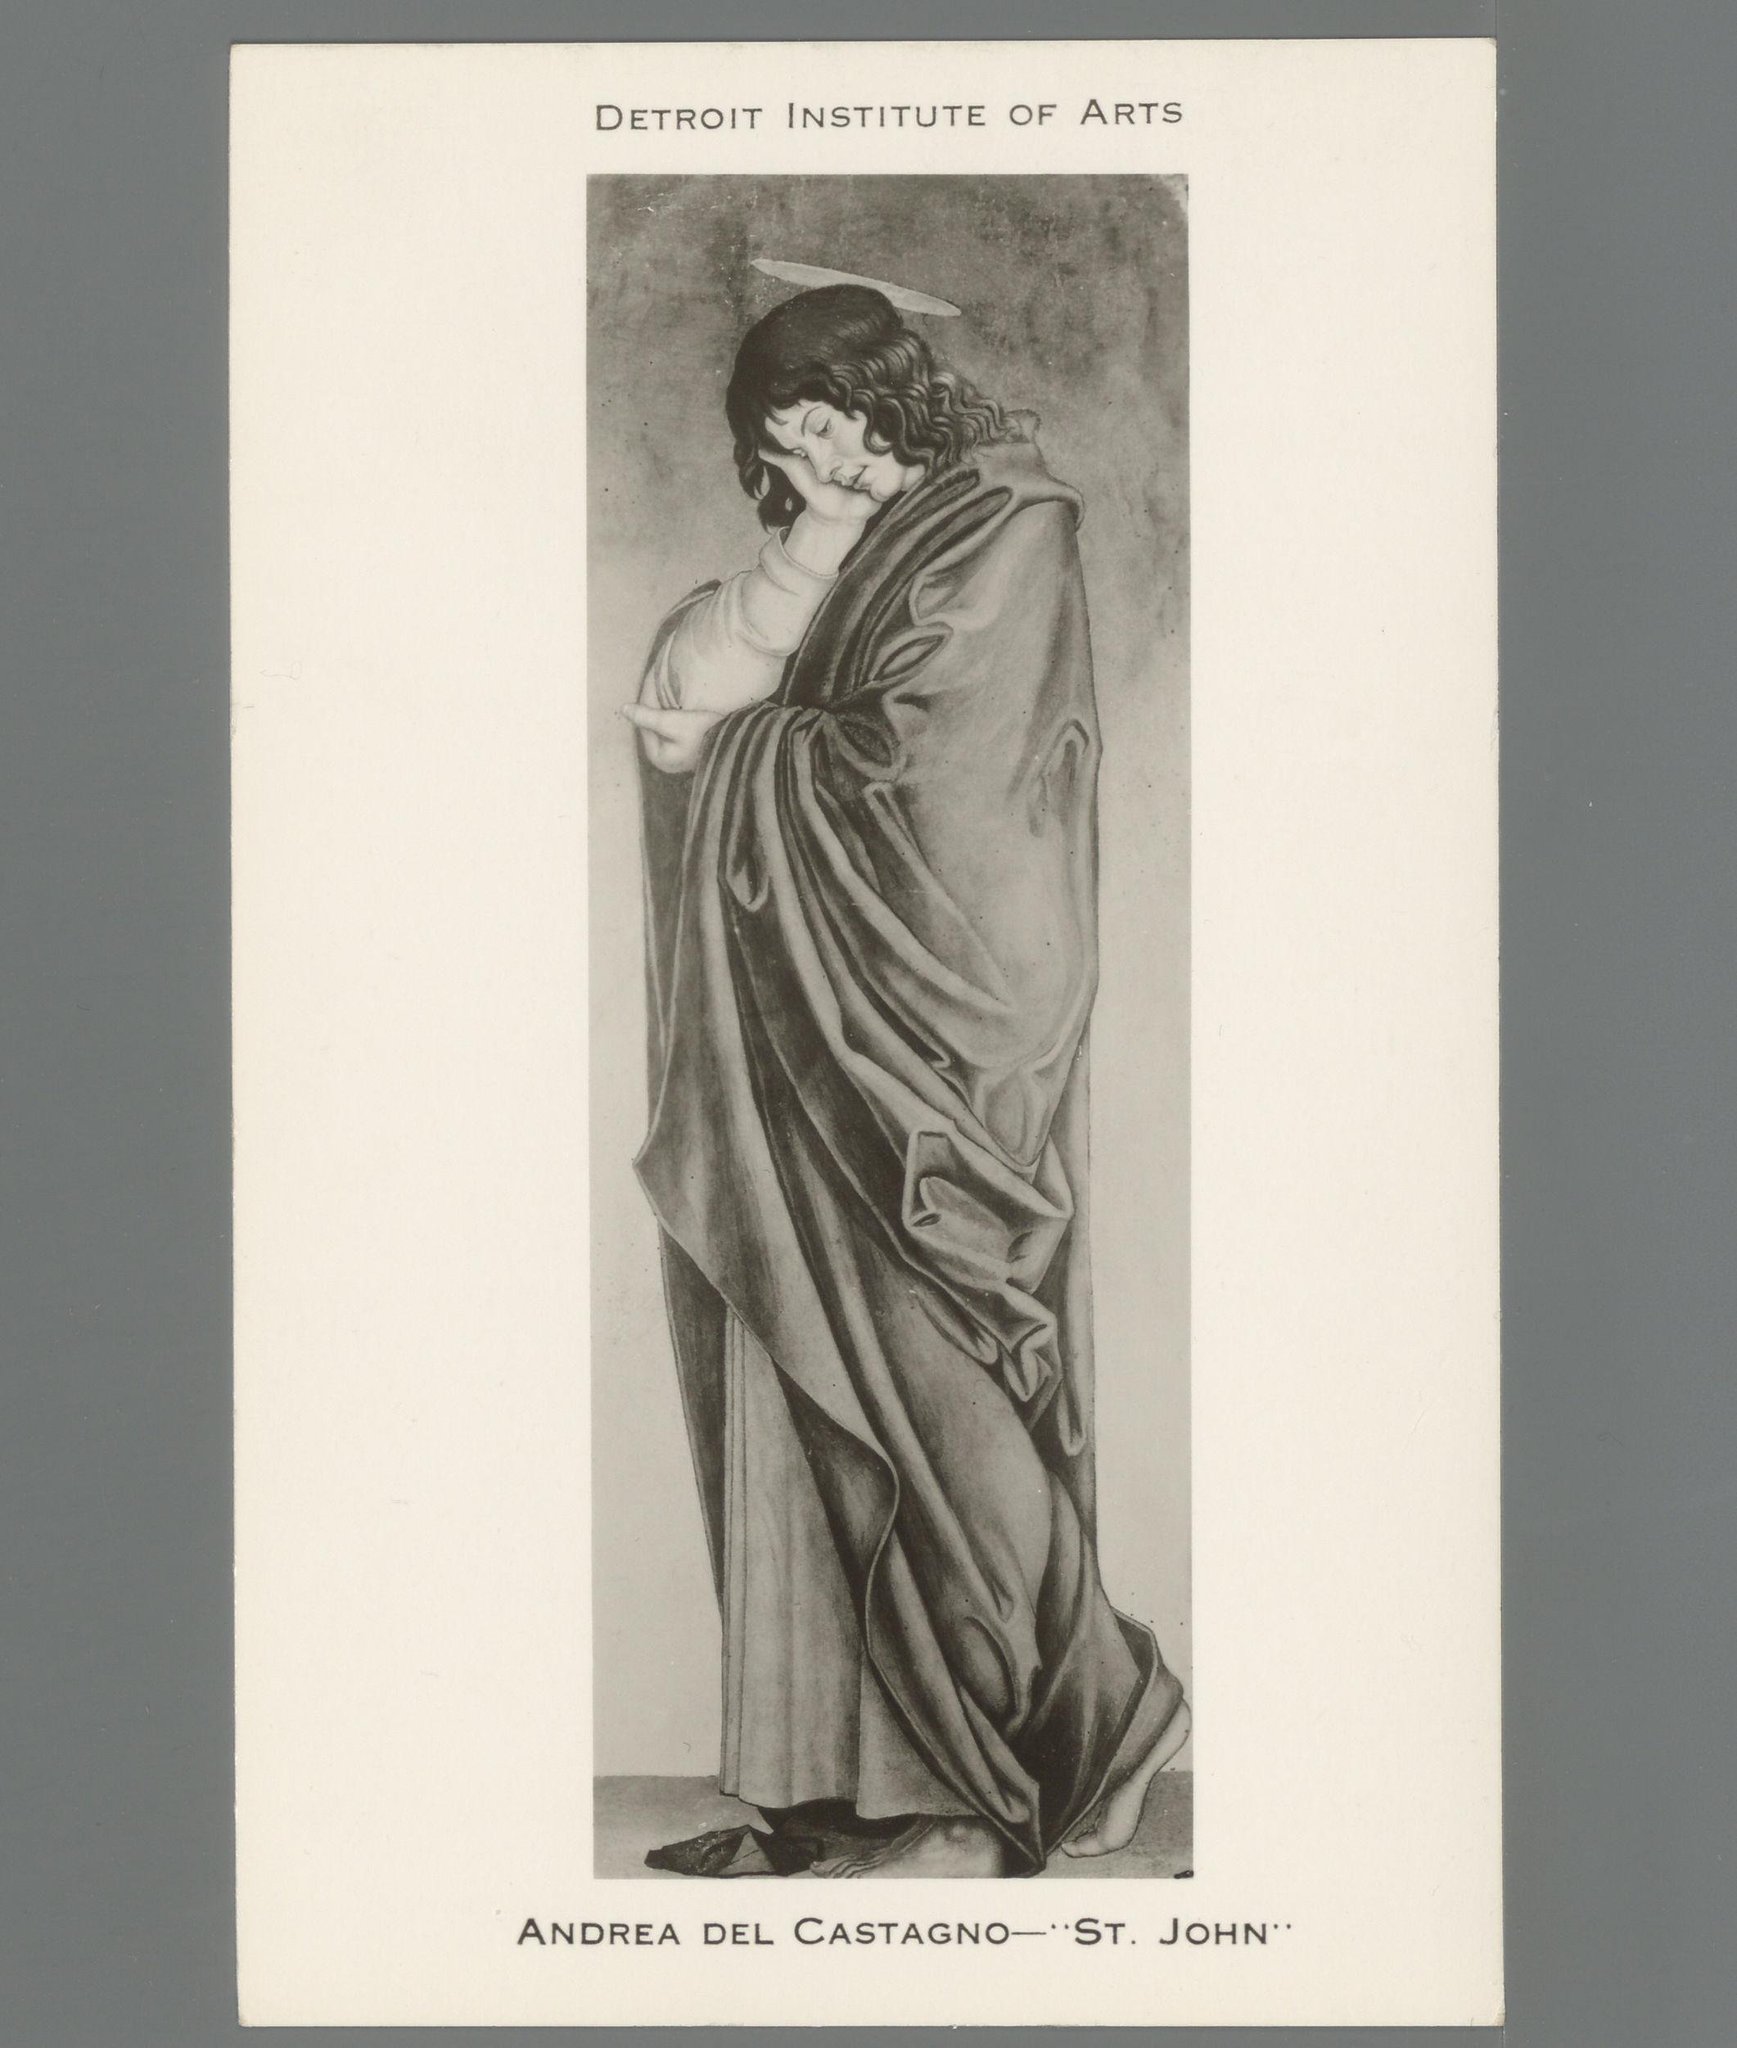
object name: reproduction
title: St. John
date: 1937-1945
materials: photographic support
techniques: photography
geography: detroit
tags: the apostle john the evangelist; possible attributes: book, cauldron, chalice with snake, eagle, palm, scroll